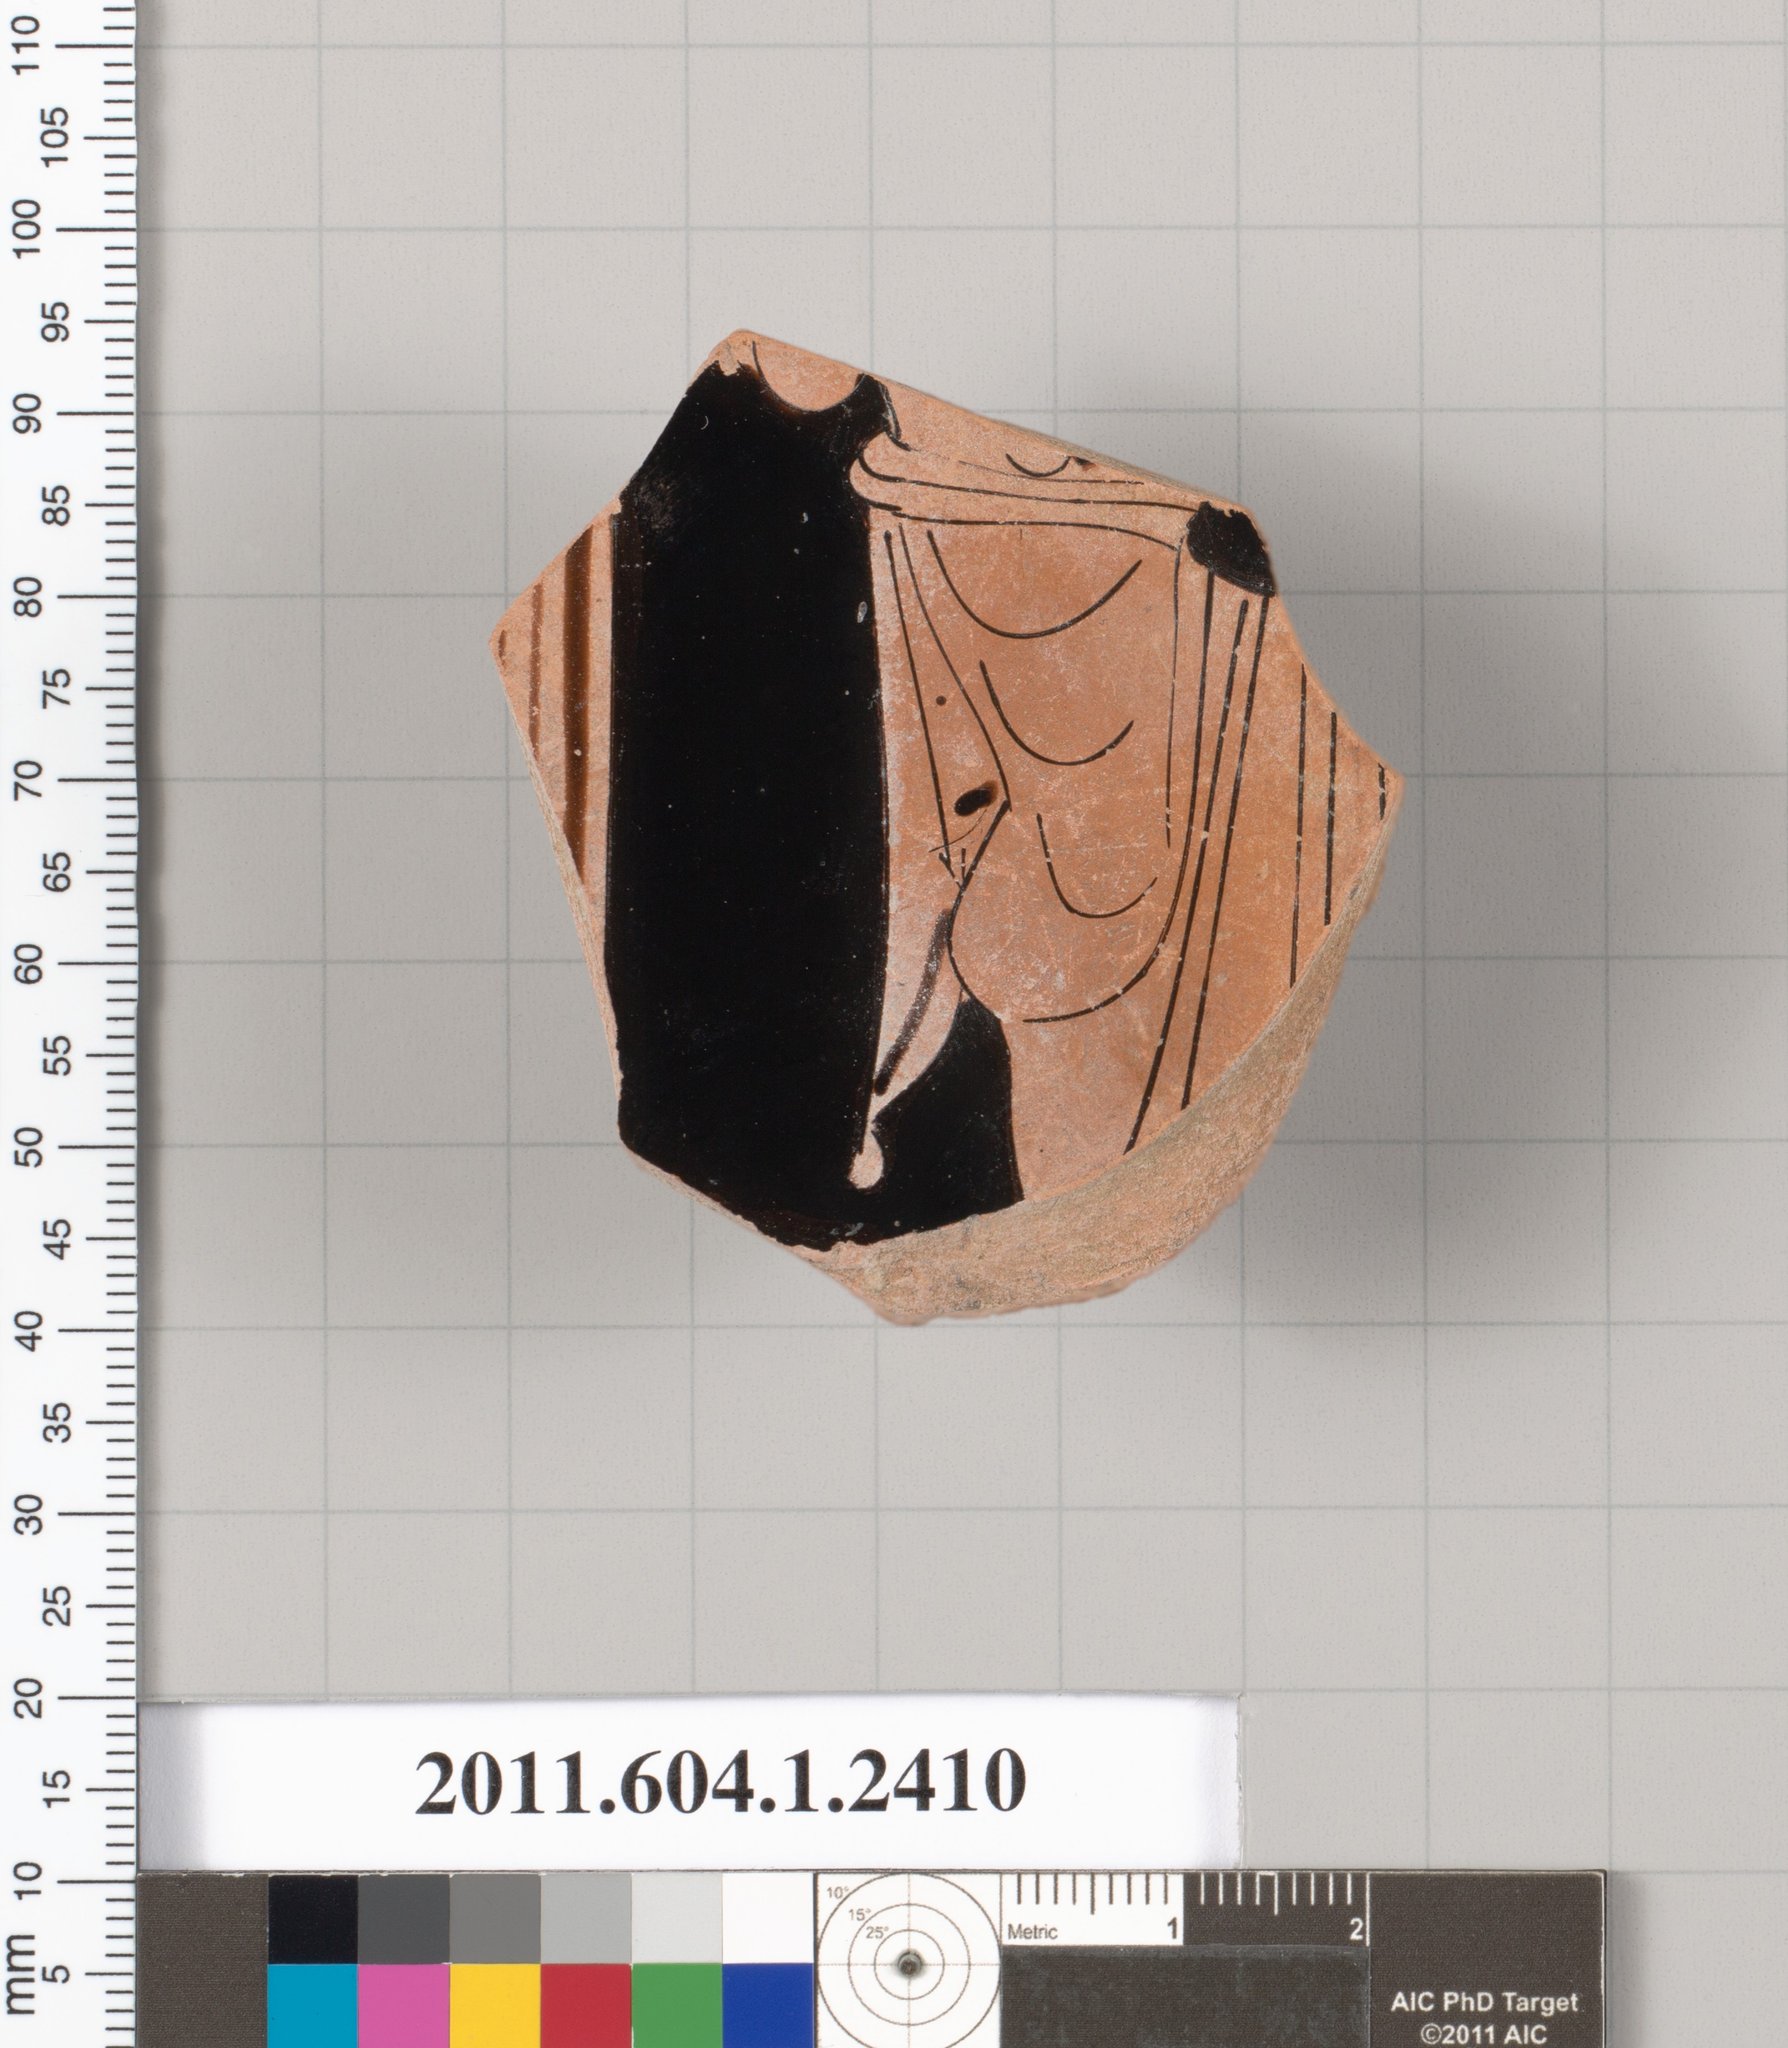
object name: kylix fragment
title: Terracotta fragment of a kylix (drinking cup)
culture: greek, attic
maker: painter of the yale cup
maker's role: artist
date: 475-451 BCE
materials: terracotta